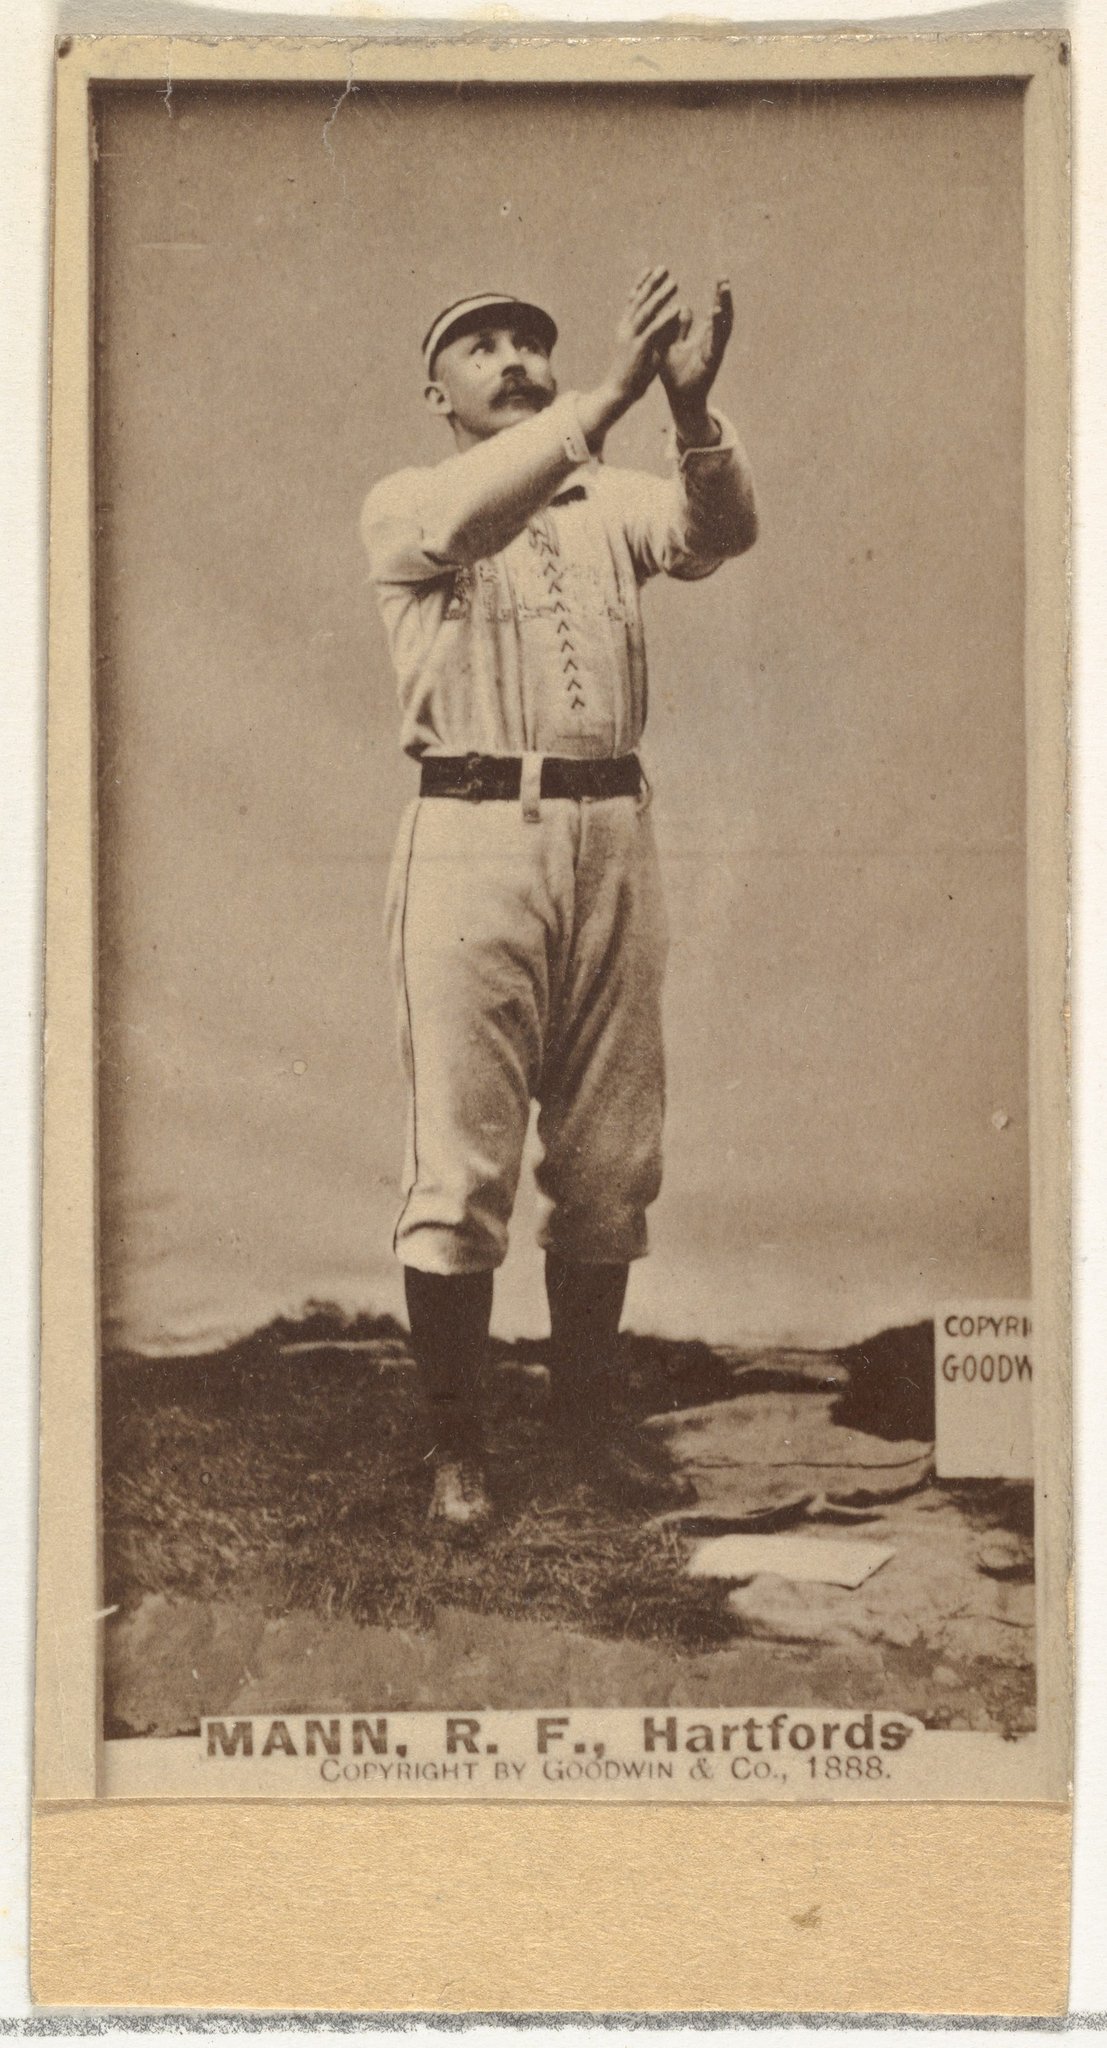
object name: baseball card, photograph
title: Fred J. Mann, Right Field, Hartford, from the Old Judge series (N172) for Old Judge Cigarettes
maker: goodwin & company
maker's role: publisher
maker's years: 1850-1950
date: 1888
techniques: albumen silver print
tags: men,portraits,baseball,athletes